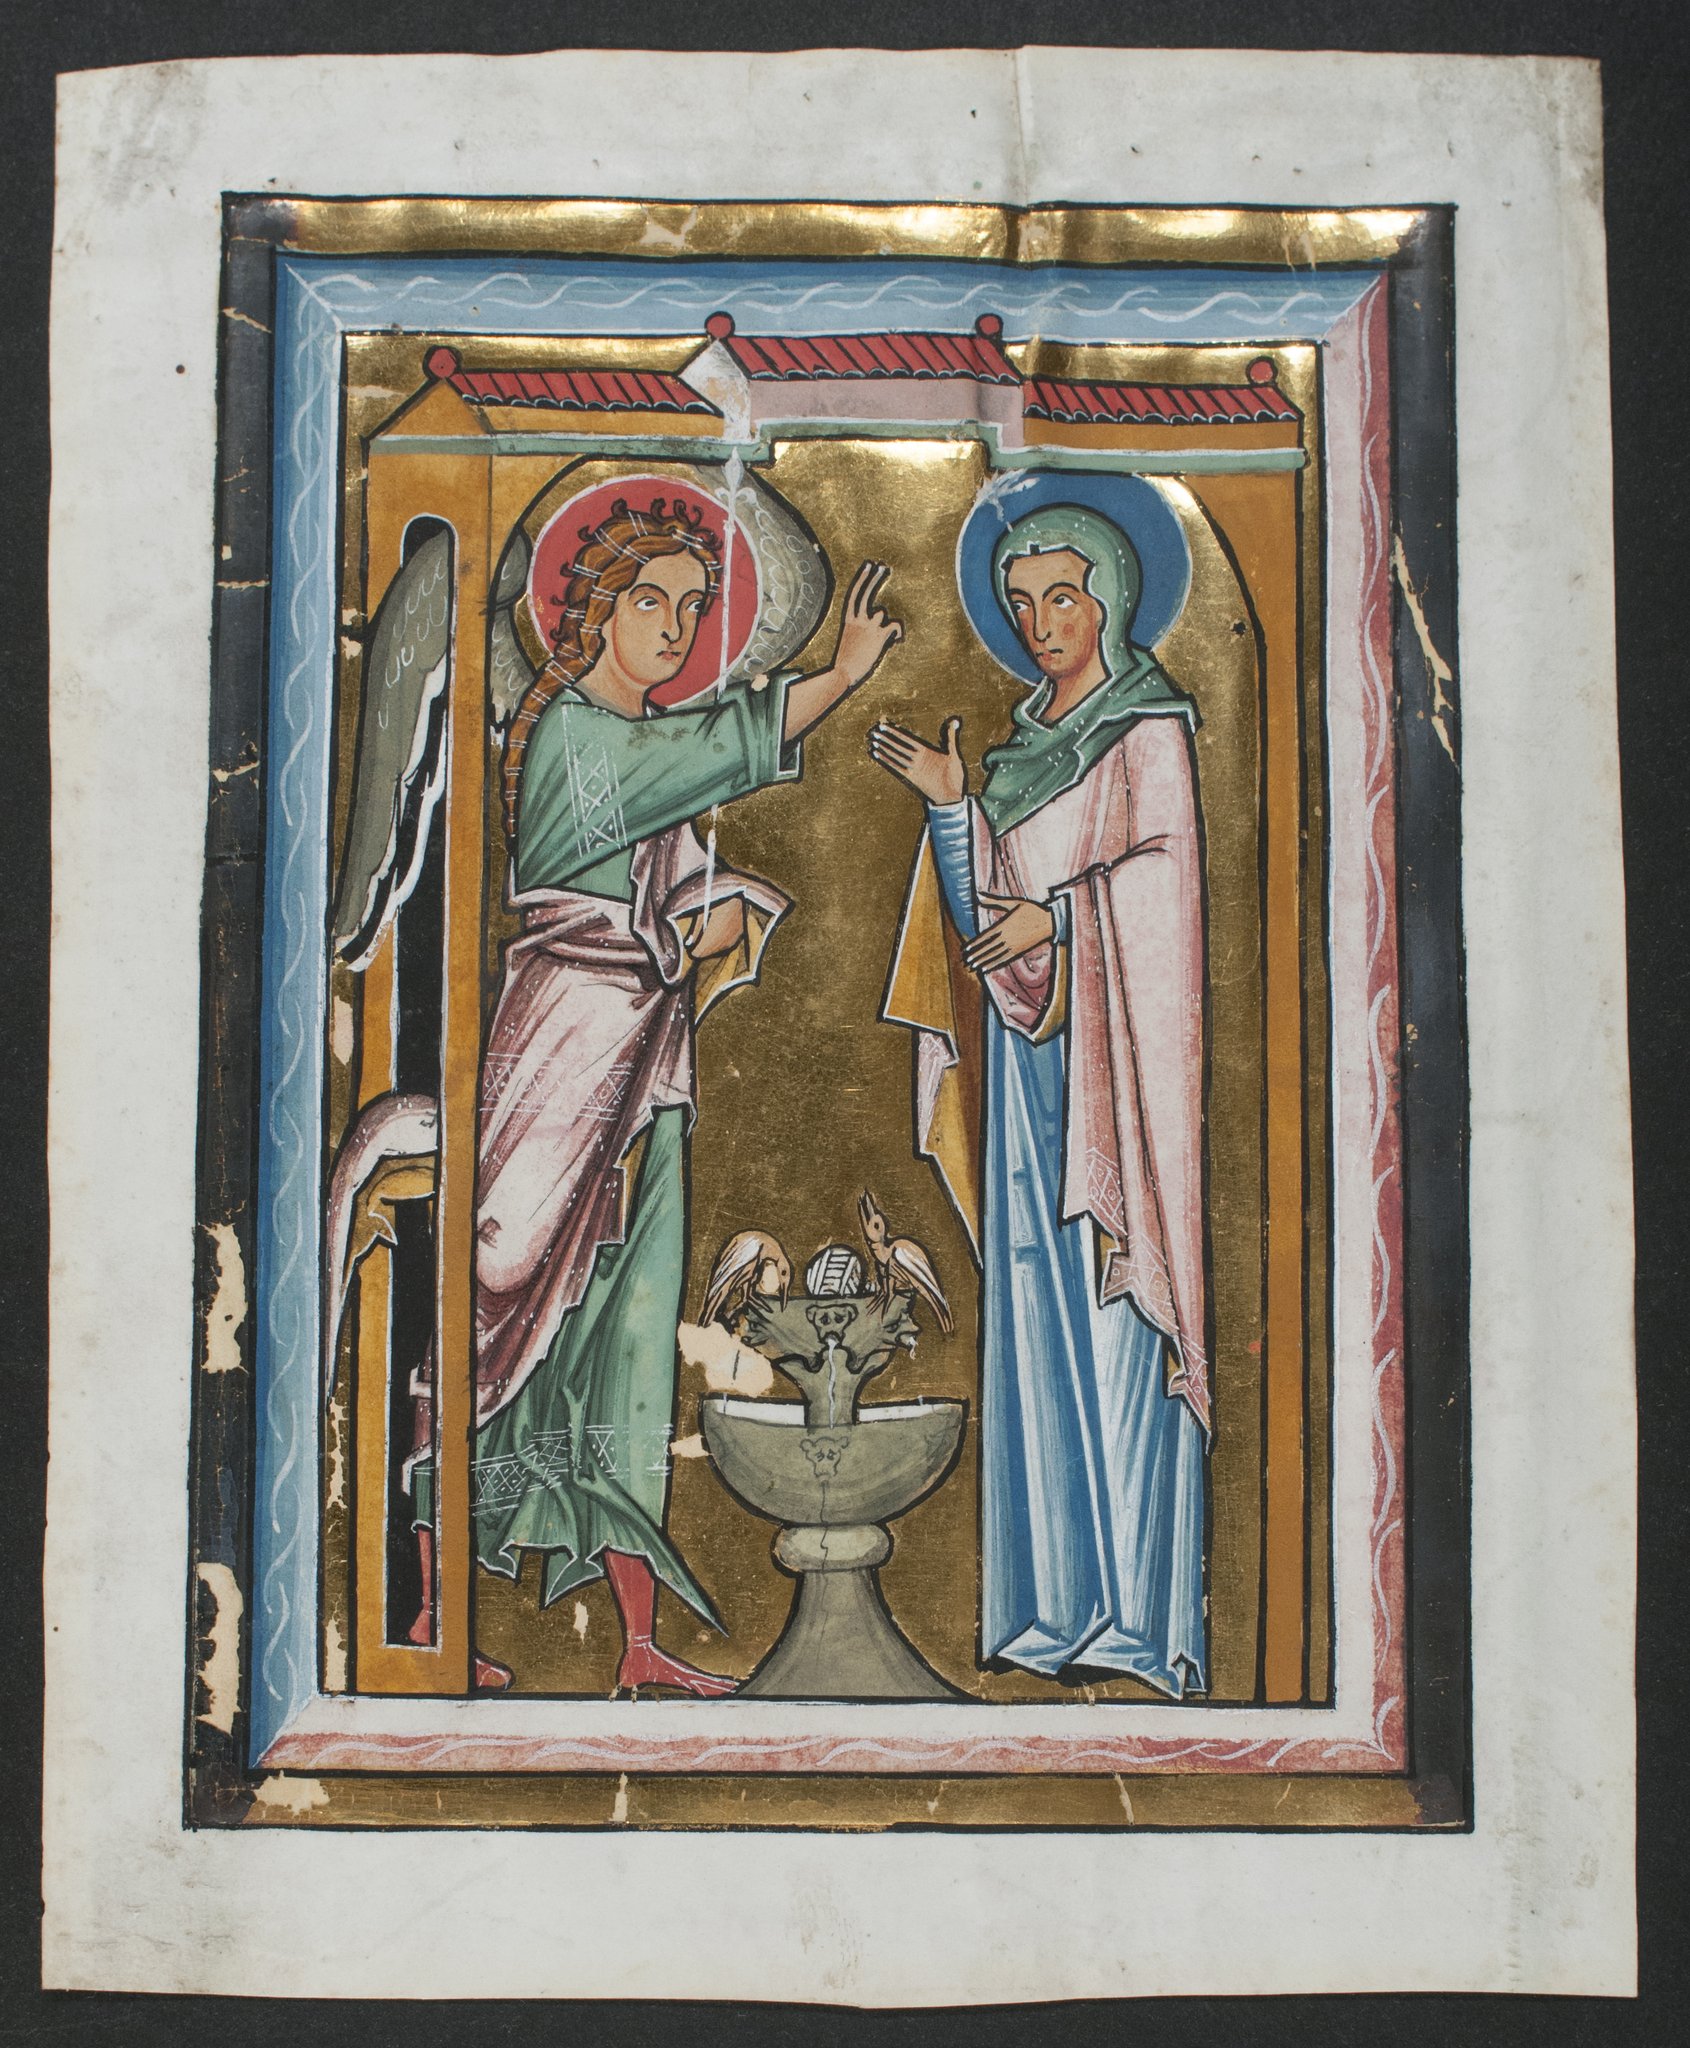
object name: psalter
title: Manuscript Leaf with the Annunciation, from a Psalter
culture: german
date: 1234-1266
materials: gold, ink, parchment, silver, paint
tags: virgin mary,archangel gabriel,annunciation